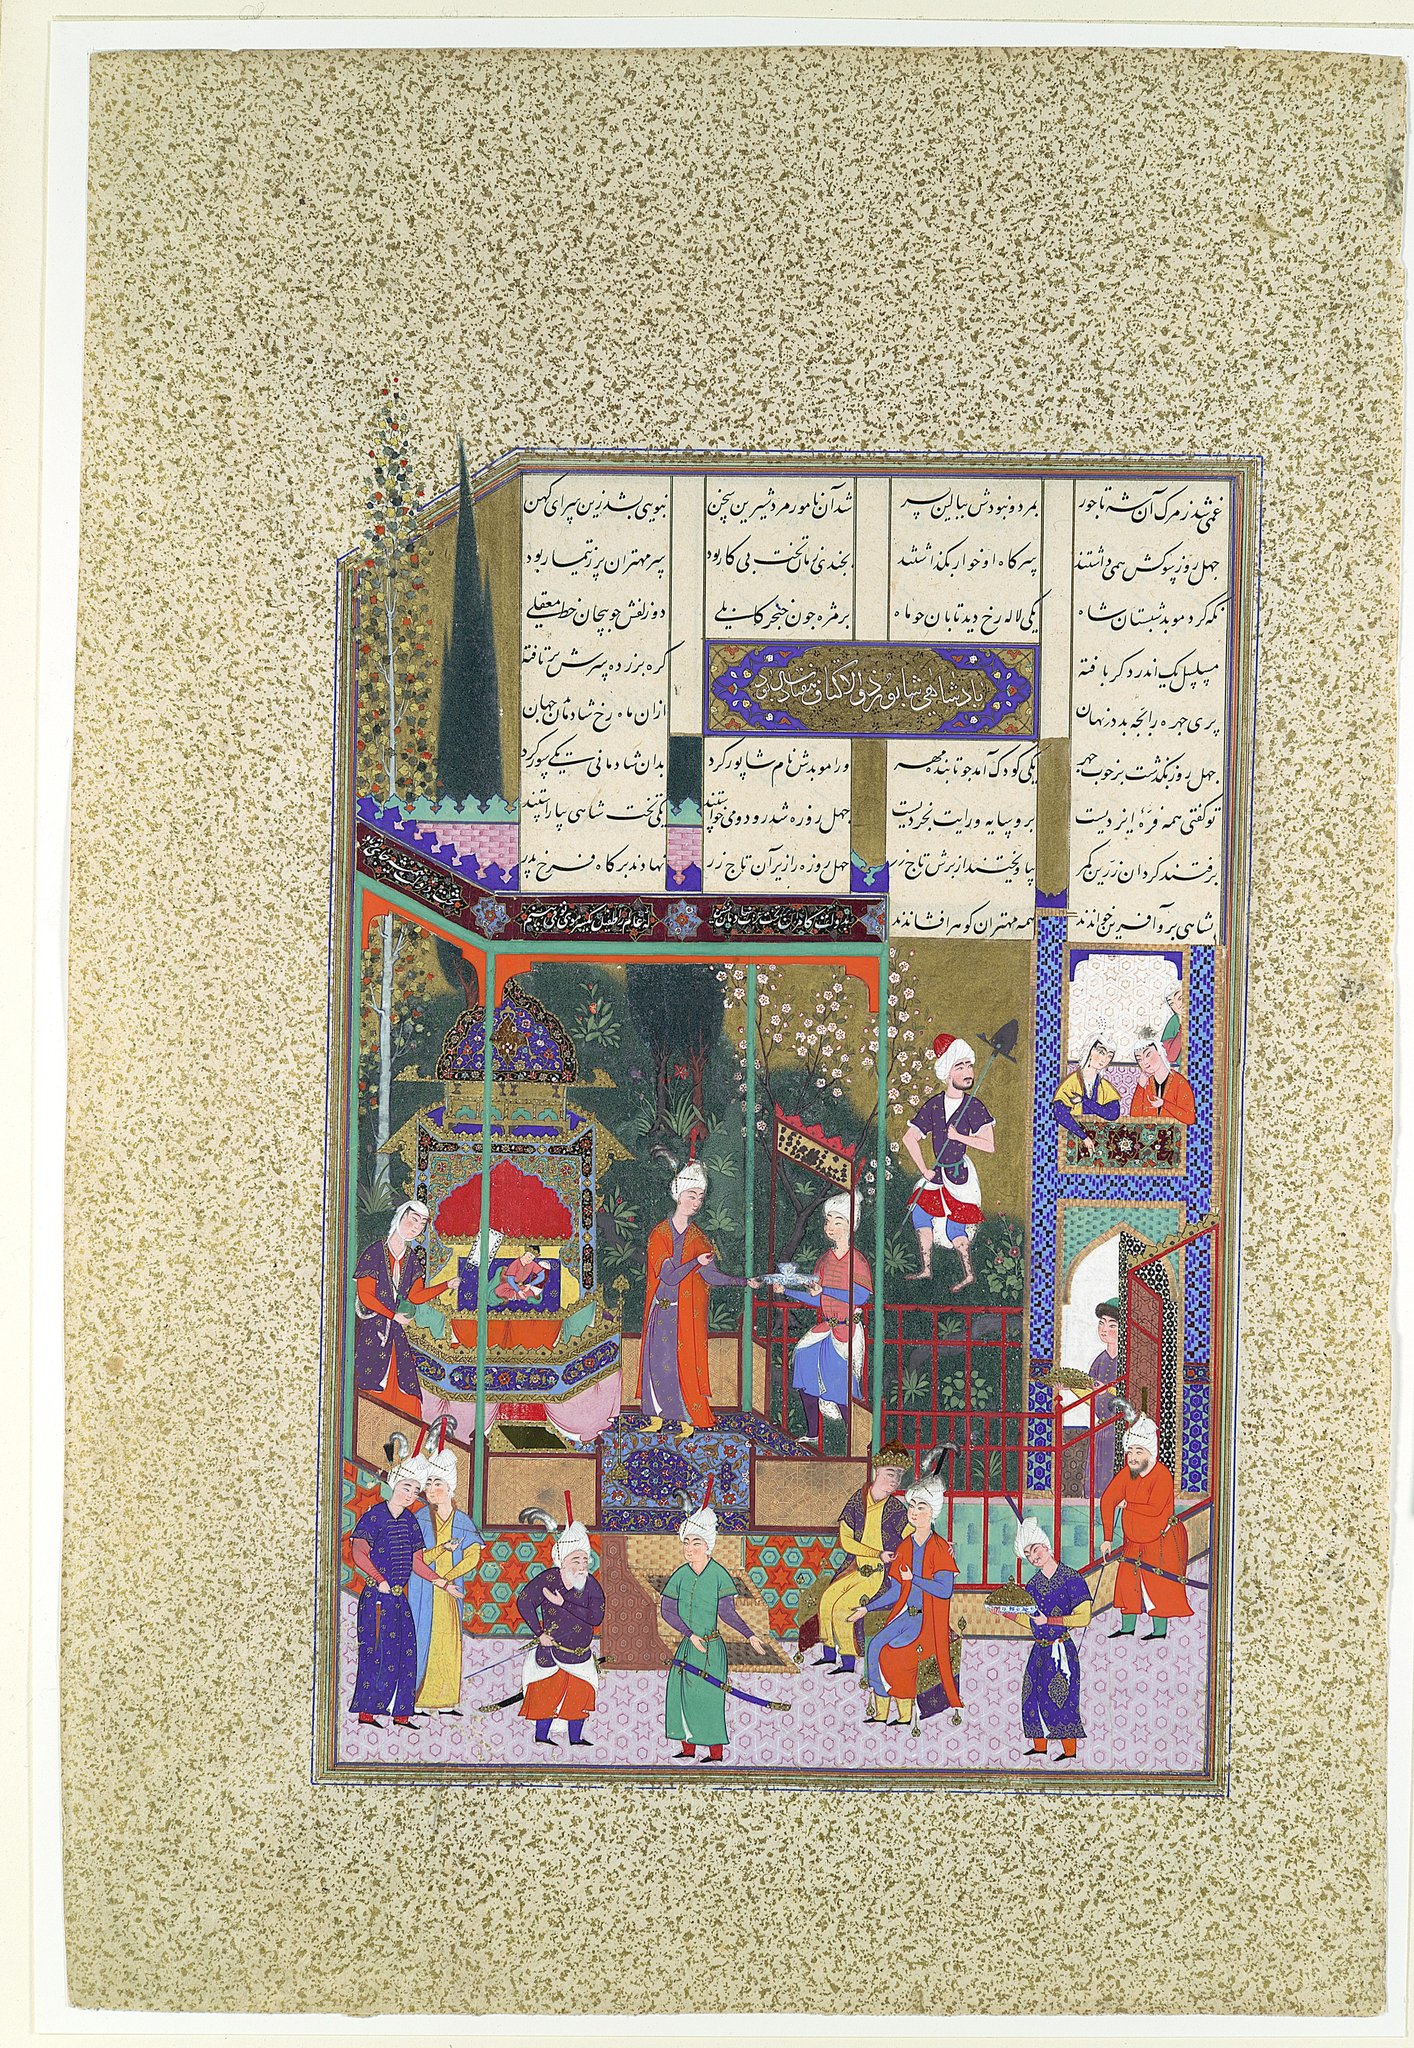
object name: folio from an illustrated manuscript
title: "The Coronation of the Infant Shapur II", Folio 538r from the Shahnama (Book of Kings) of Shah Tahmasp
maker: abu'l qasim firdausi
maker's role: author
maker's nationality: iranian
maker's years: 935-1020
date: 1525-1530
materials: gold, ink, paper, silver, watercolor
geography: iran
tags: men,women